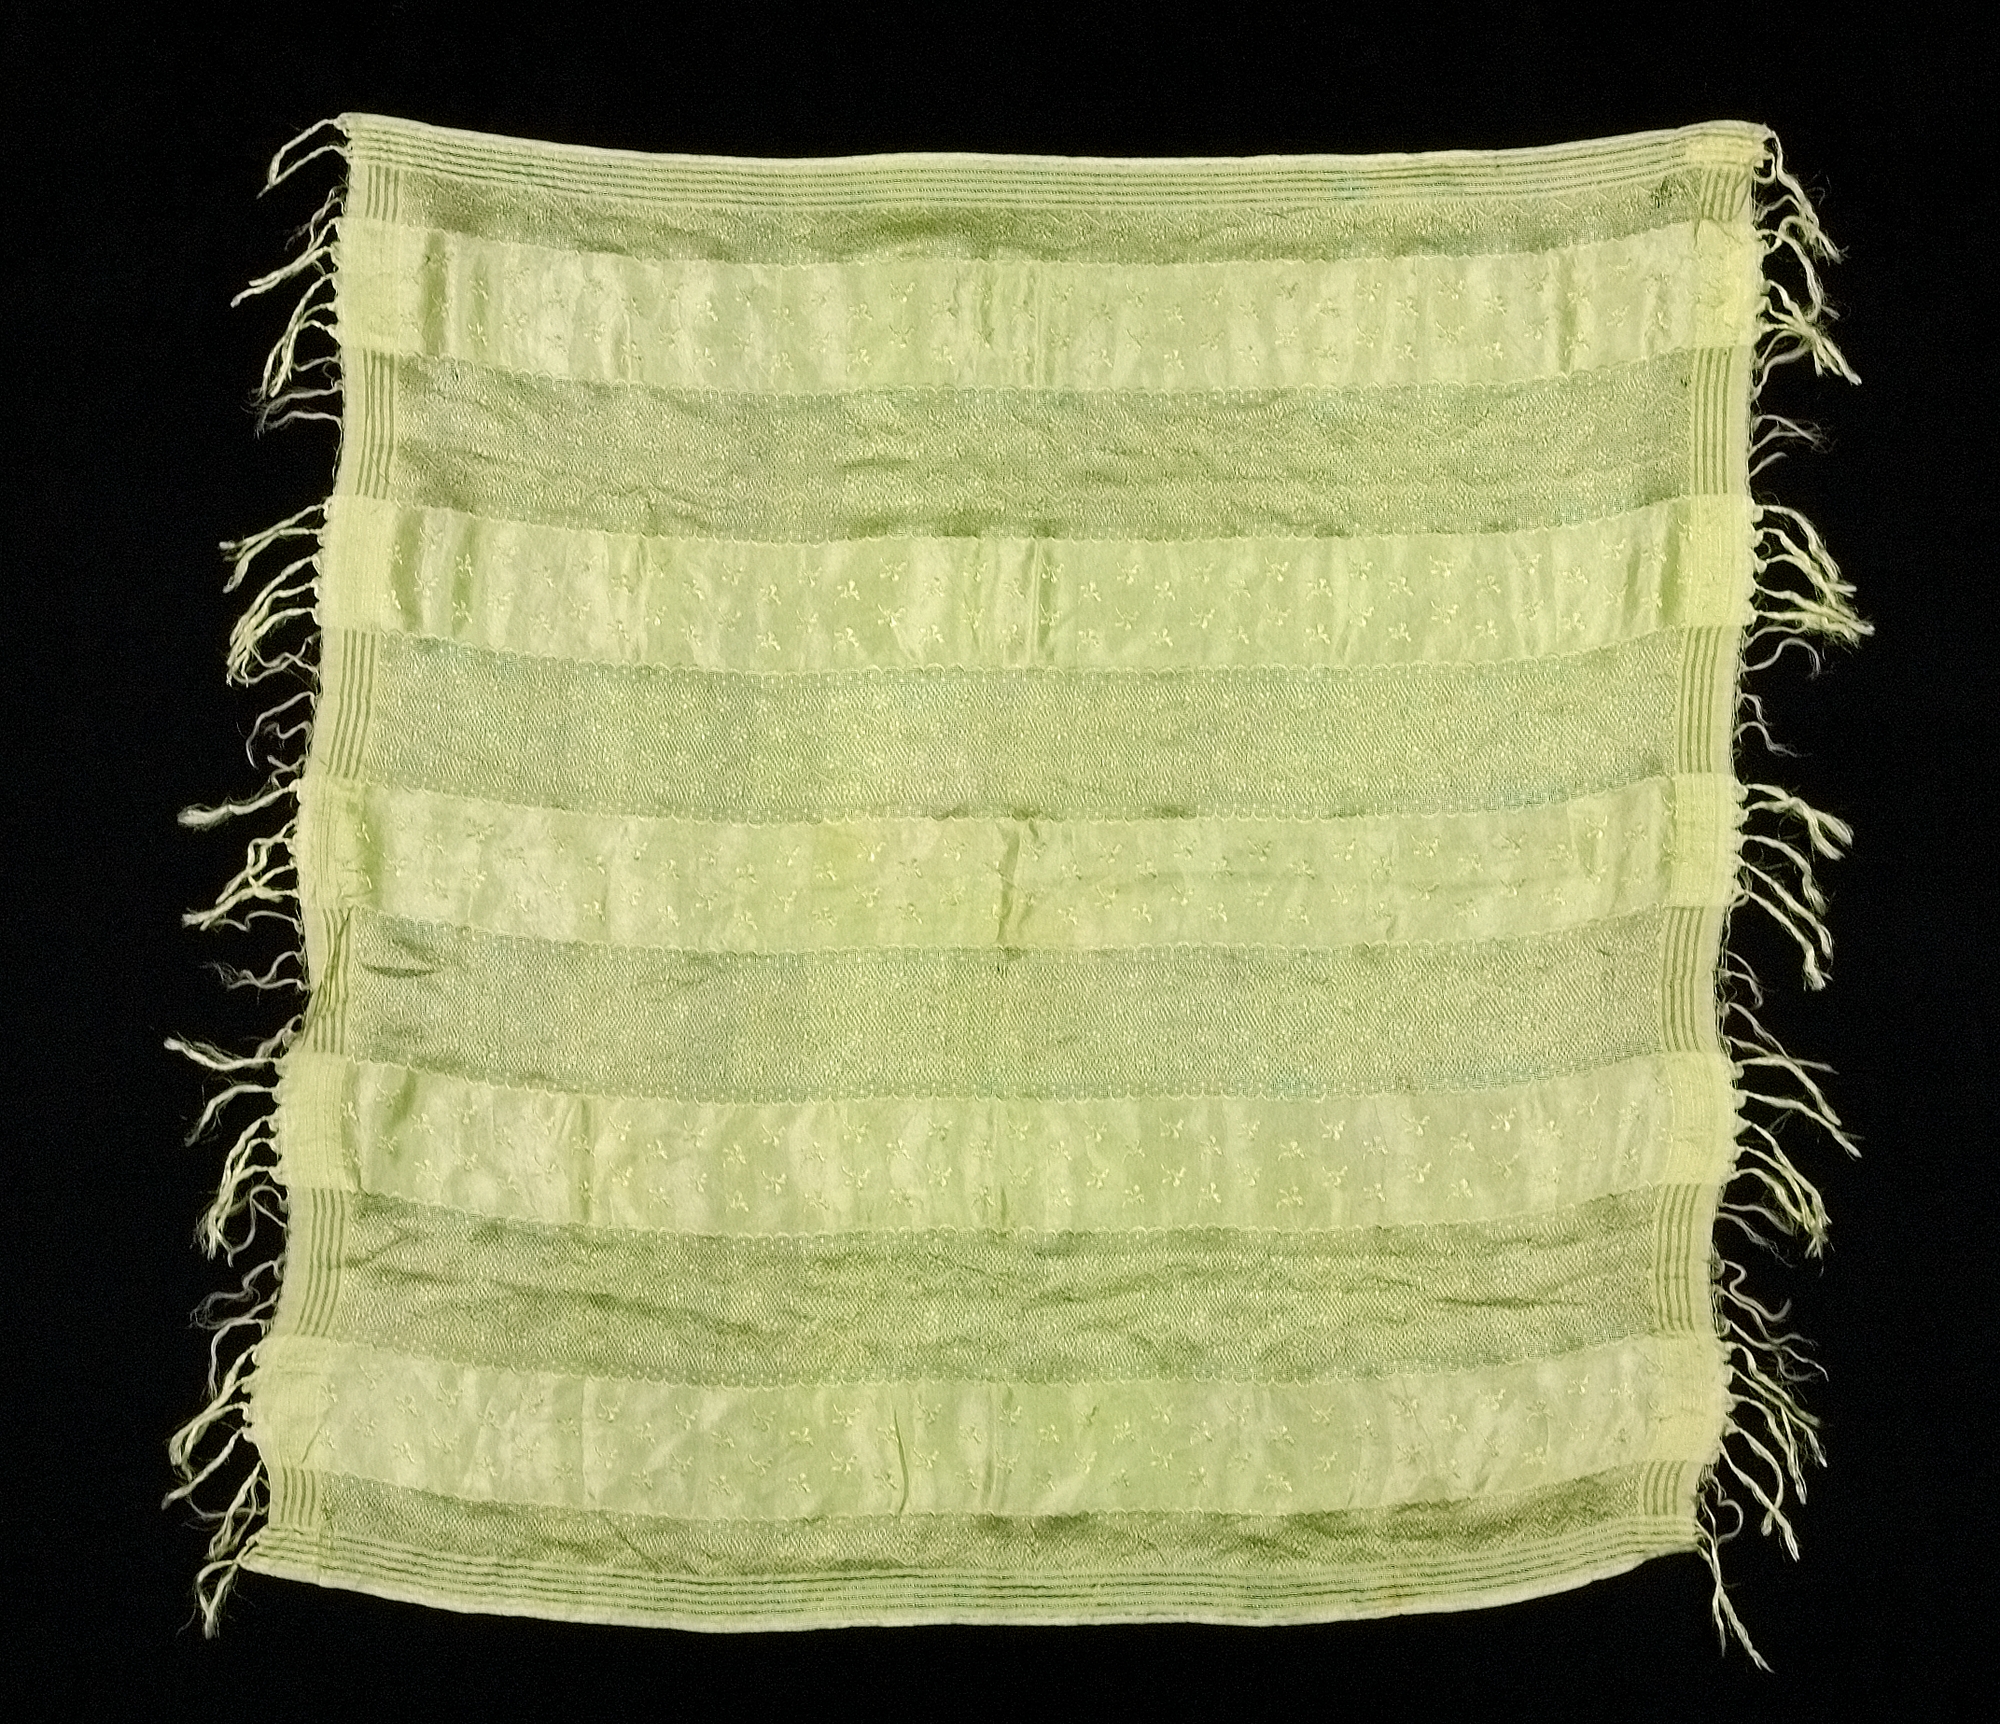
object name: scarf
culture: american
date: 1851-1875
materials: silk